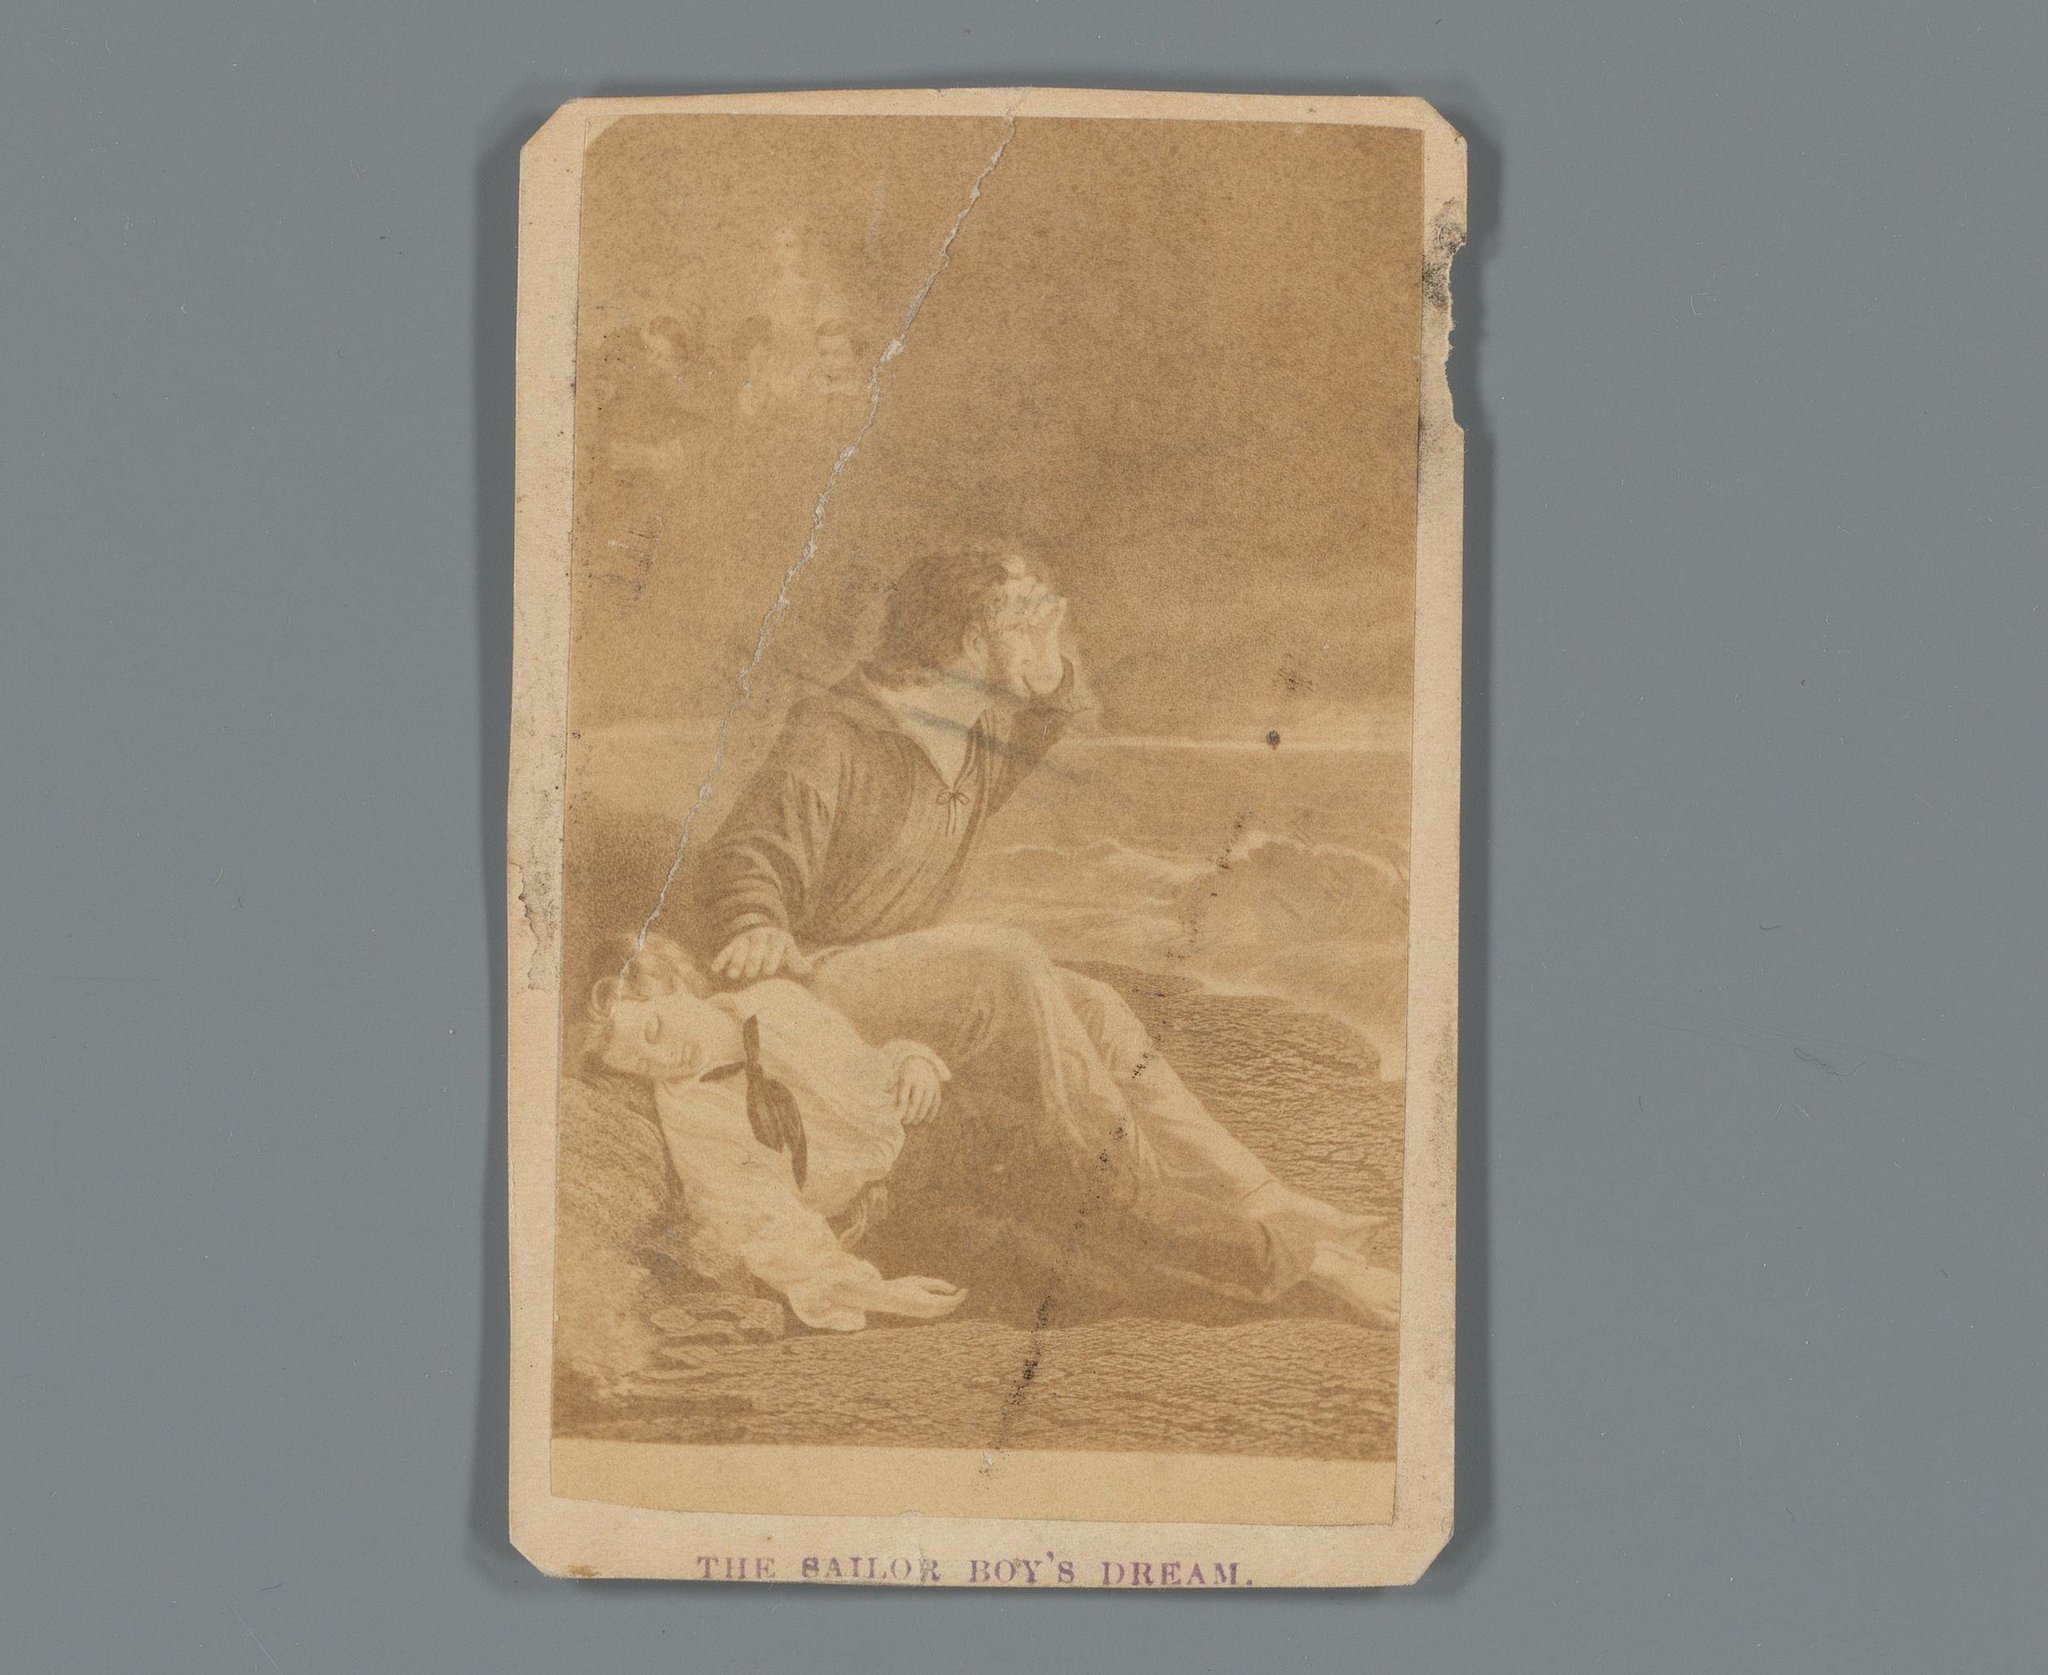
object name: reproduction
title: The Sailor Boy's Dream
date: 1850-1915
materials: cardboard, photographic support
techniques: albumen print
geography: new orleans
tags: advertising, seaman: sailor, beach, textile industry and clothing industry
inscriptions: inscription: ‘PIERSON & HEWS, Successors to PITKIN, PIERSON & CO/ DEALERS IN/ FINE CLOTHING/ AND/ FURNISHING GOODS/ No.s 13 and 15 Camp Street,/ Wm. H. Pierson,/ E.L. Hews/ New Orleans’